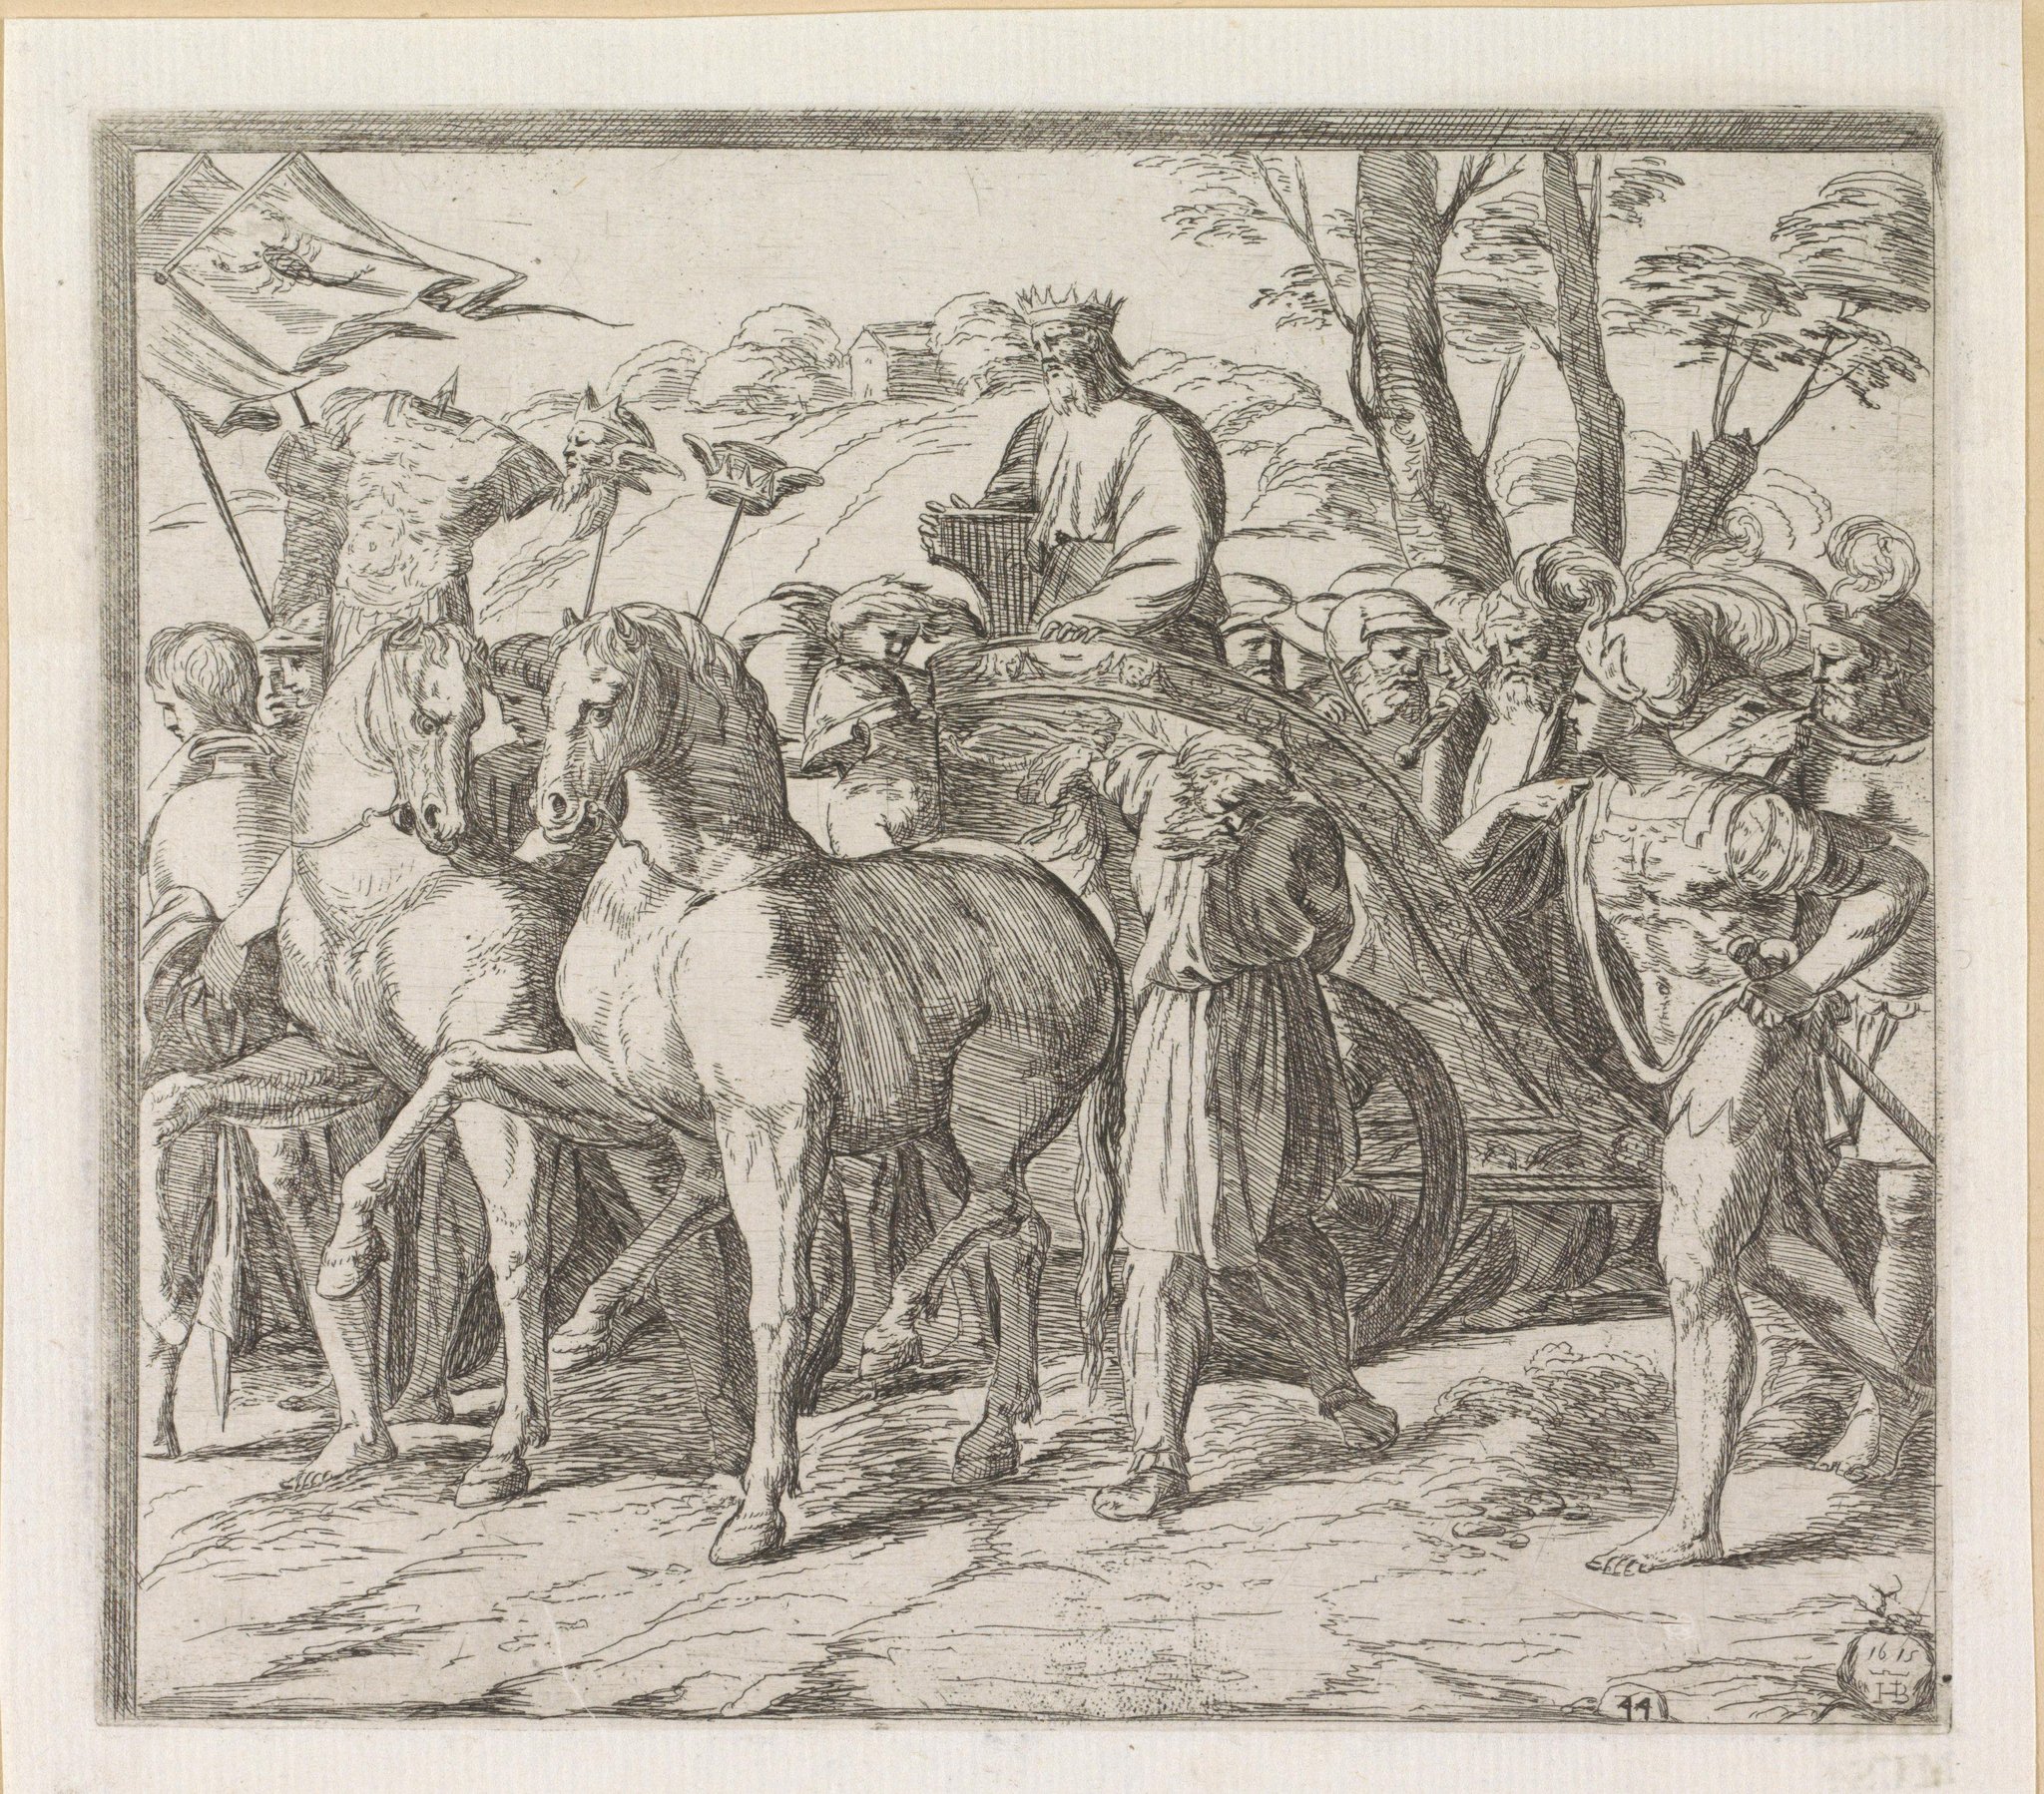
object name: print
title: David keert in triomf terug naar Jeruzalem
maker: orazio borgianni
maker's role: print maker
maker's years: 1578-1616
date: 1615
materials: paper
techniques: etching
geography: italy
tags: david's triumph: the women of israel come out to welcome david, singing, dancing, and playing tambourines and lyres; david holding the head of goliath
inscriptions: collector's mark: Lugt 2165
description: Koning David en zijn soldaten keren in triomf terug naar Jeruzalem. David staat op een triomfwagen die wordt getrokken door twee paarden.